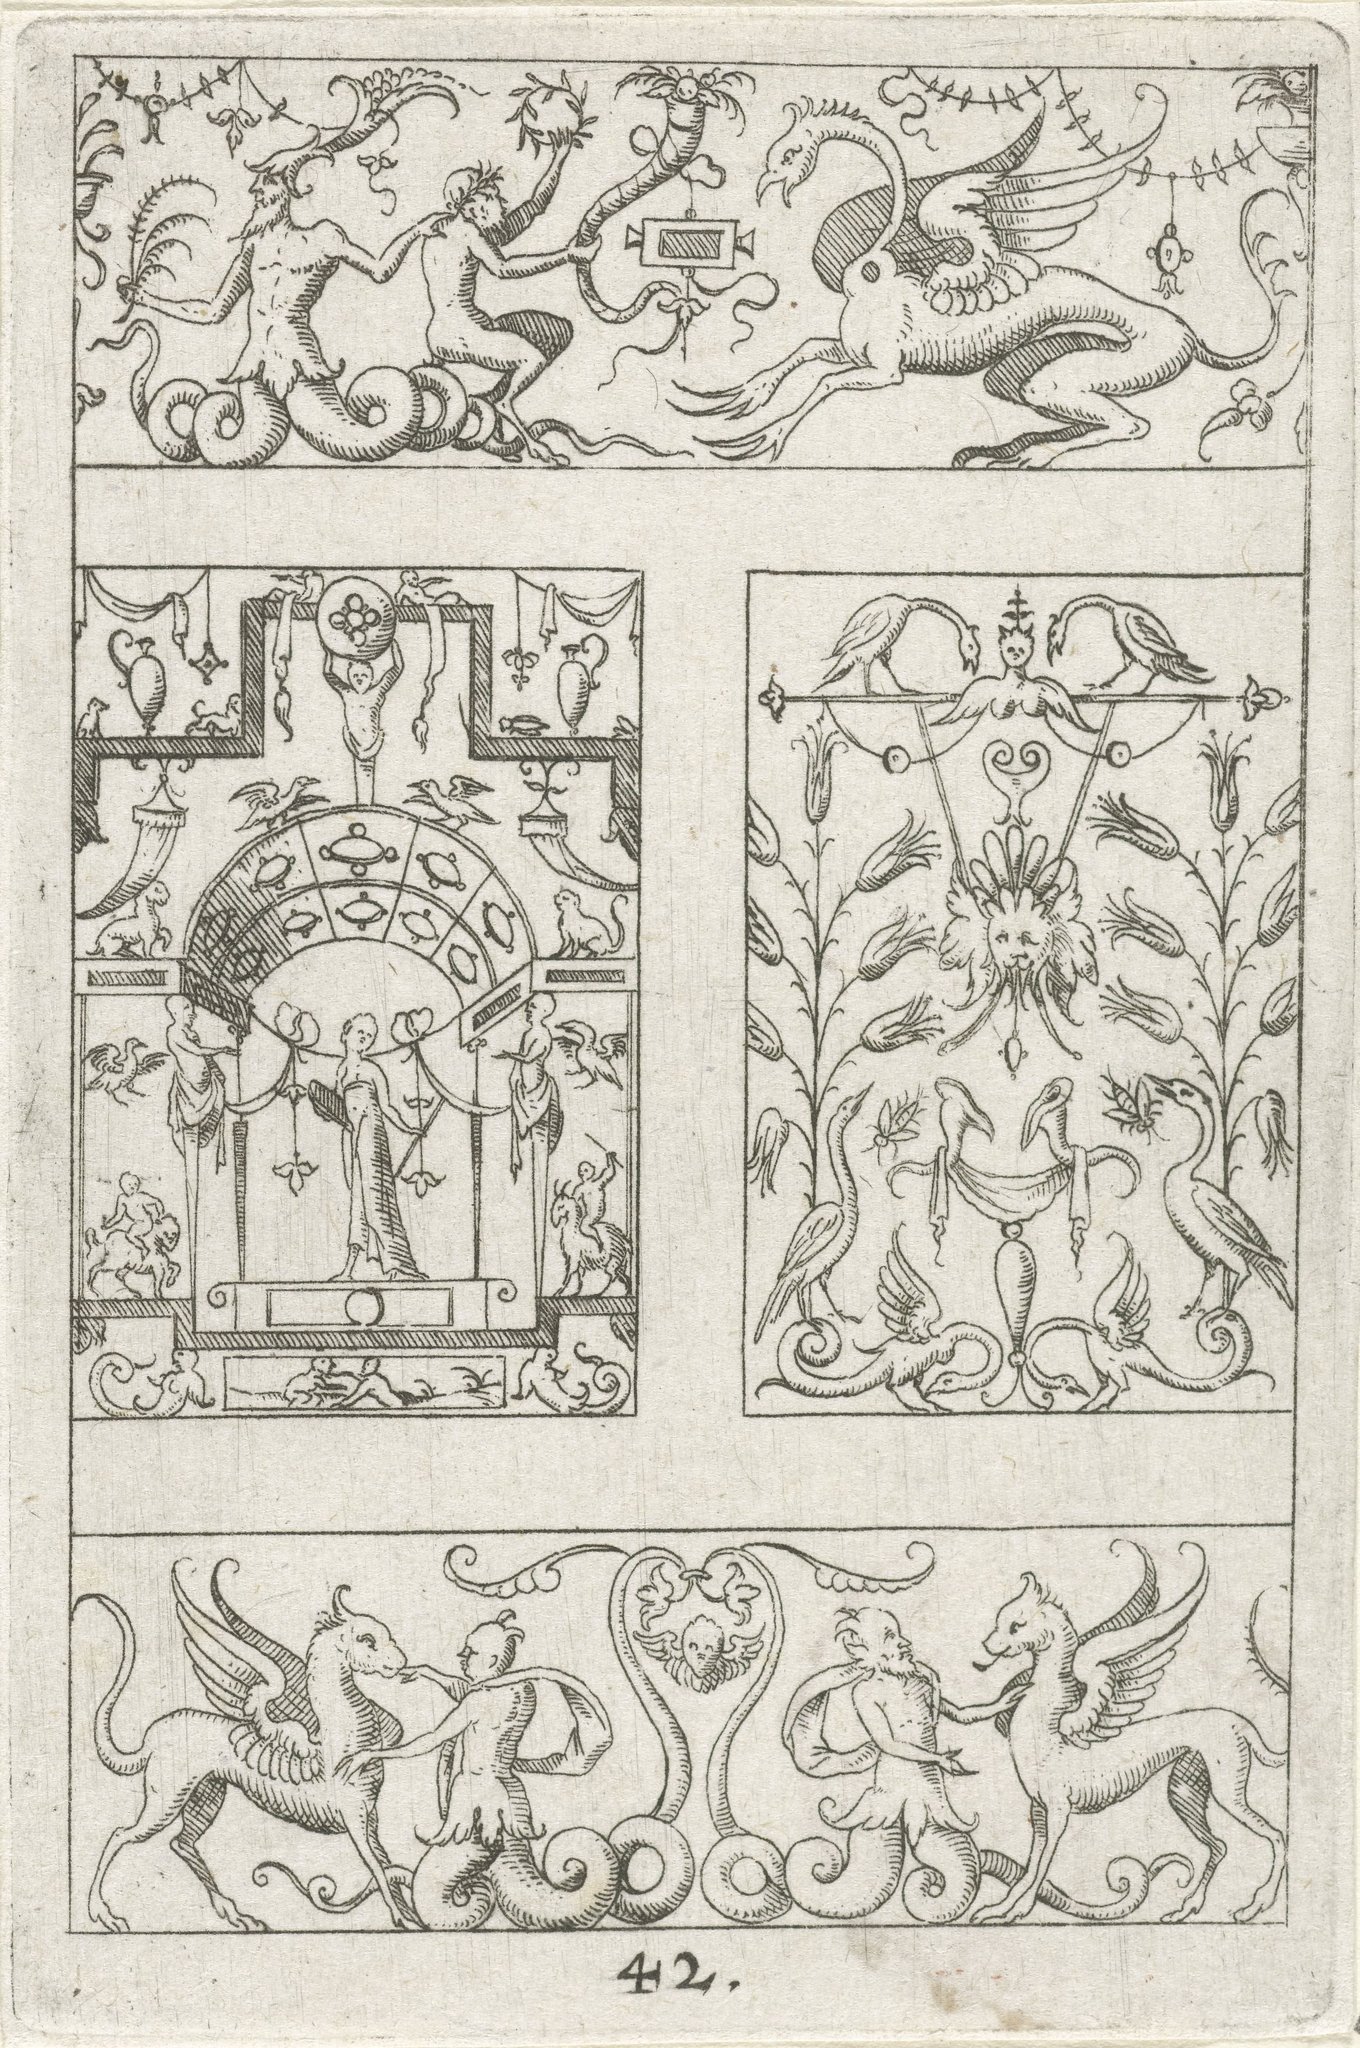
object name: print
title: Bovenaan en onderaan een fries, daartussen twee kleine vlakdecoraties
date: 1525-1594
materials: paper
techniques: etching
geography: germany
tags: ornament derived from architectural details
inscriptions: collector's mark: Lugt 240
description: Gelijkzijdige kopie naar prent van Jacques Androuet Ducerceau, die de vlakdecoratie links ontleende aan een prent van Cornelis Matsys. Blad uit serie met architectuurfantasieën en grotesken met fabelwezens, guirlandes, kandelabers en mascarons.